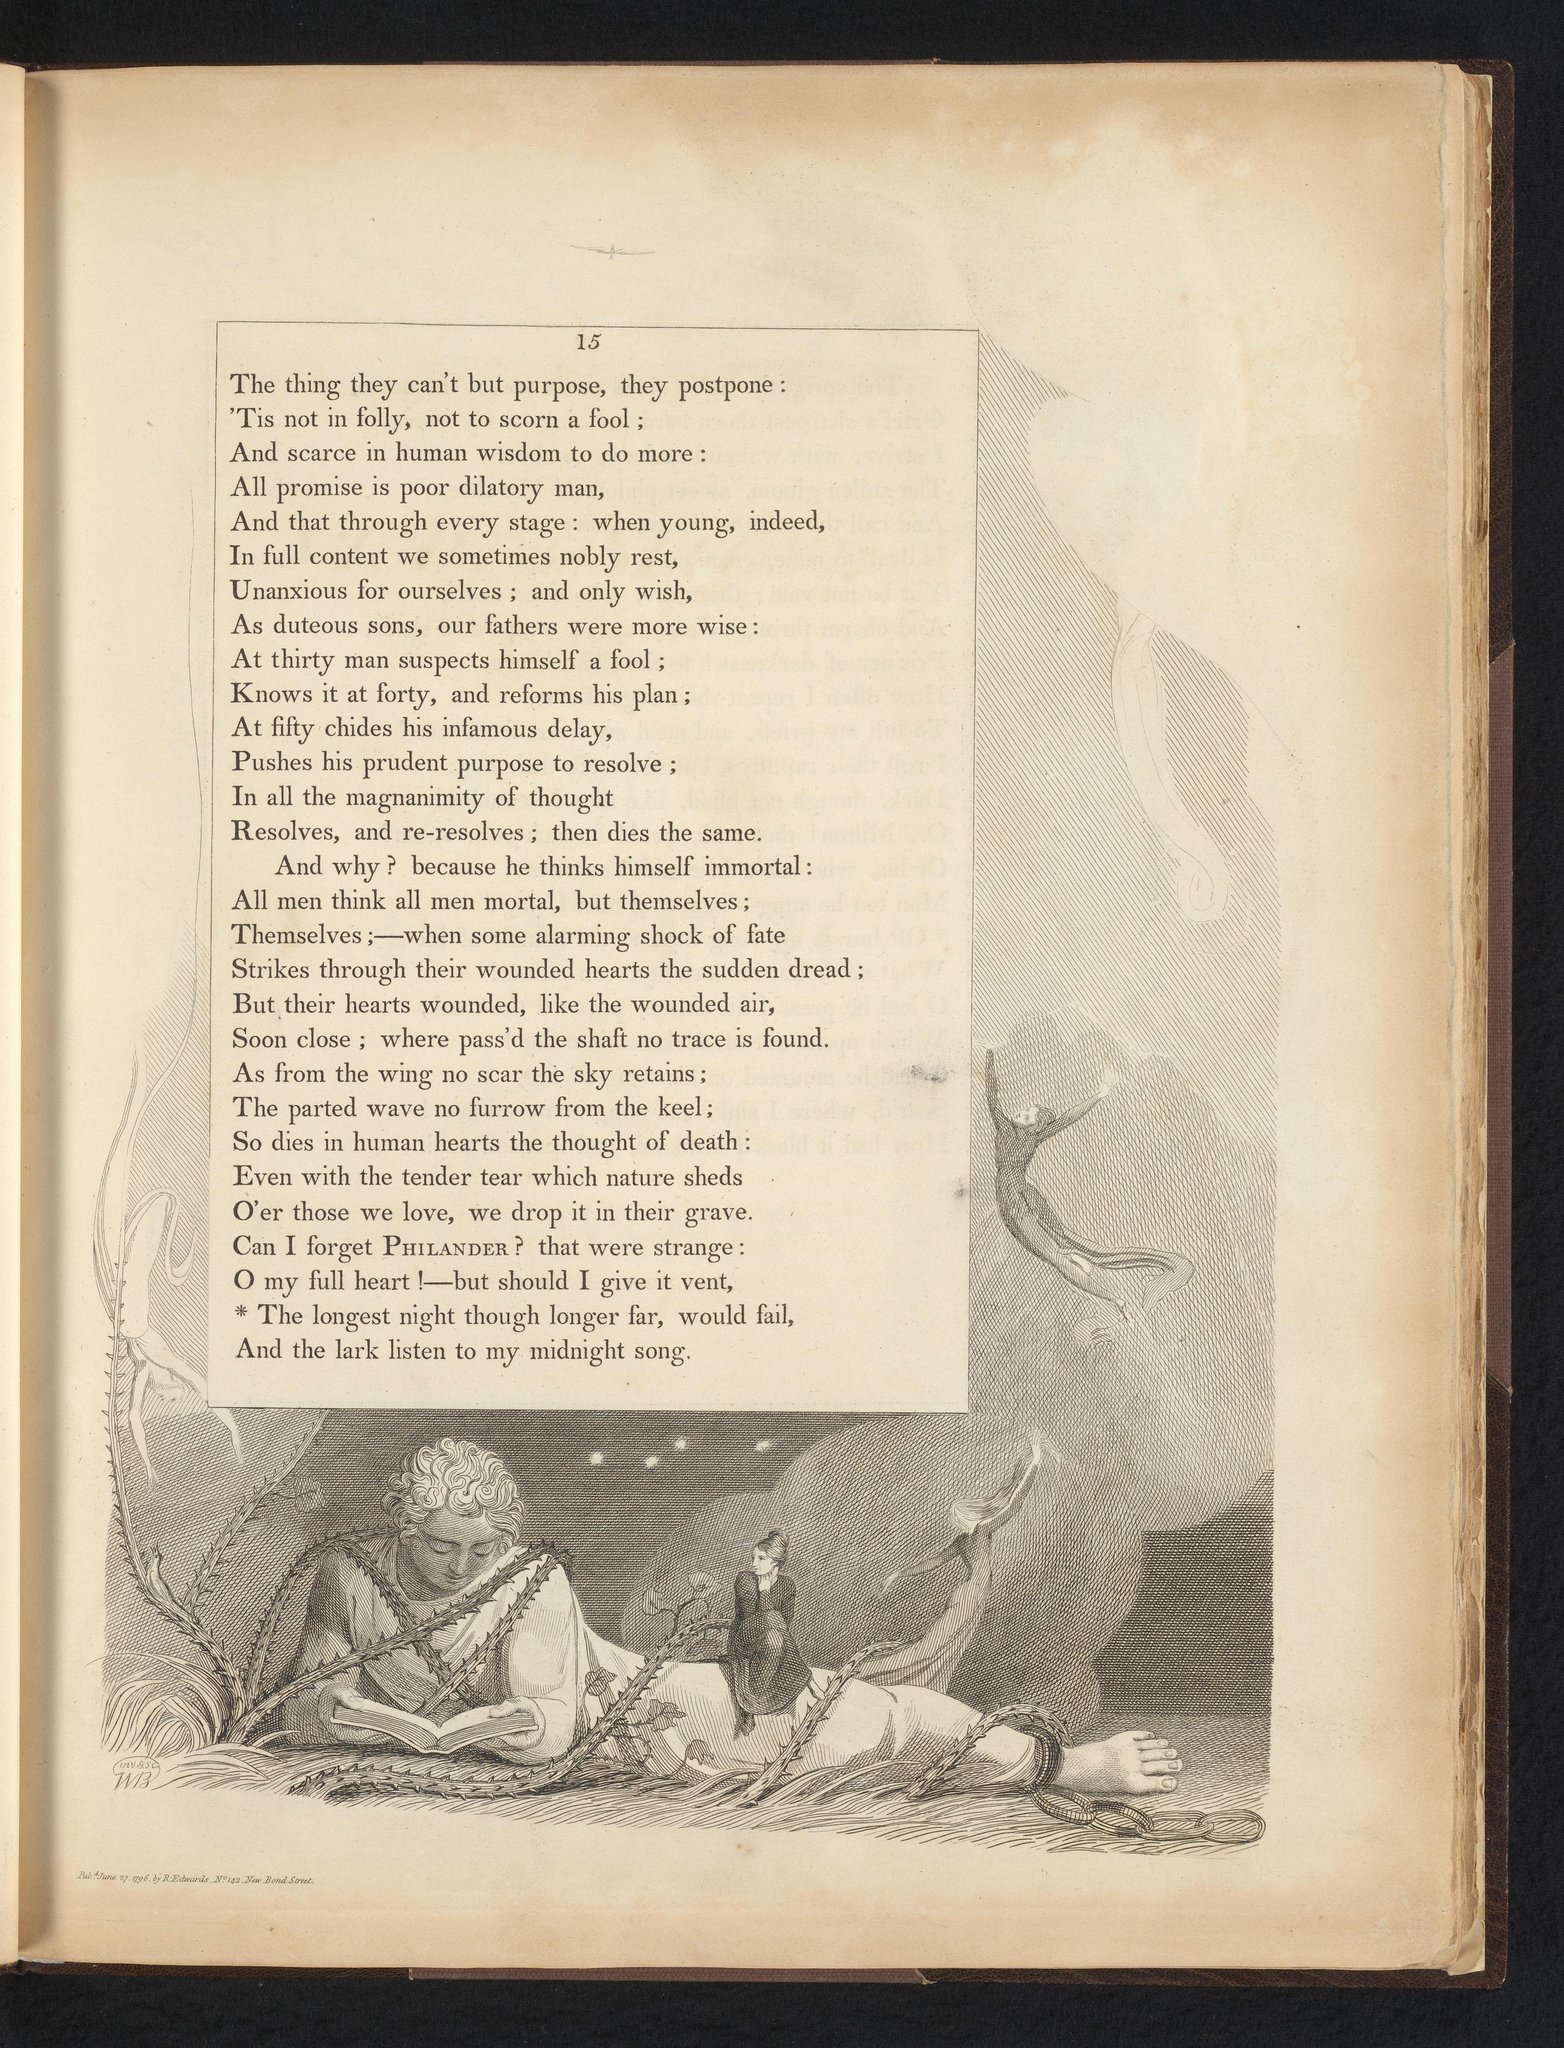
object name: print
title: Lezende man geketend met een doorntakken en een kleine vrouw op zijn been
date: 1796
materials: paper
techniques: engraving, letterpress printing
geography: london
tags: reading, adult man, imprisonment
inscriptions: : ‘The thing they can't but purpose, they postpone : (...)’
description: Prent maakt deel uit van een boek, bladzijde 15. Tekst in het Engels op recto en verso.